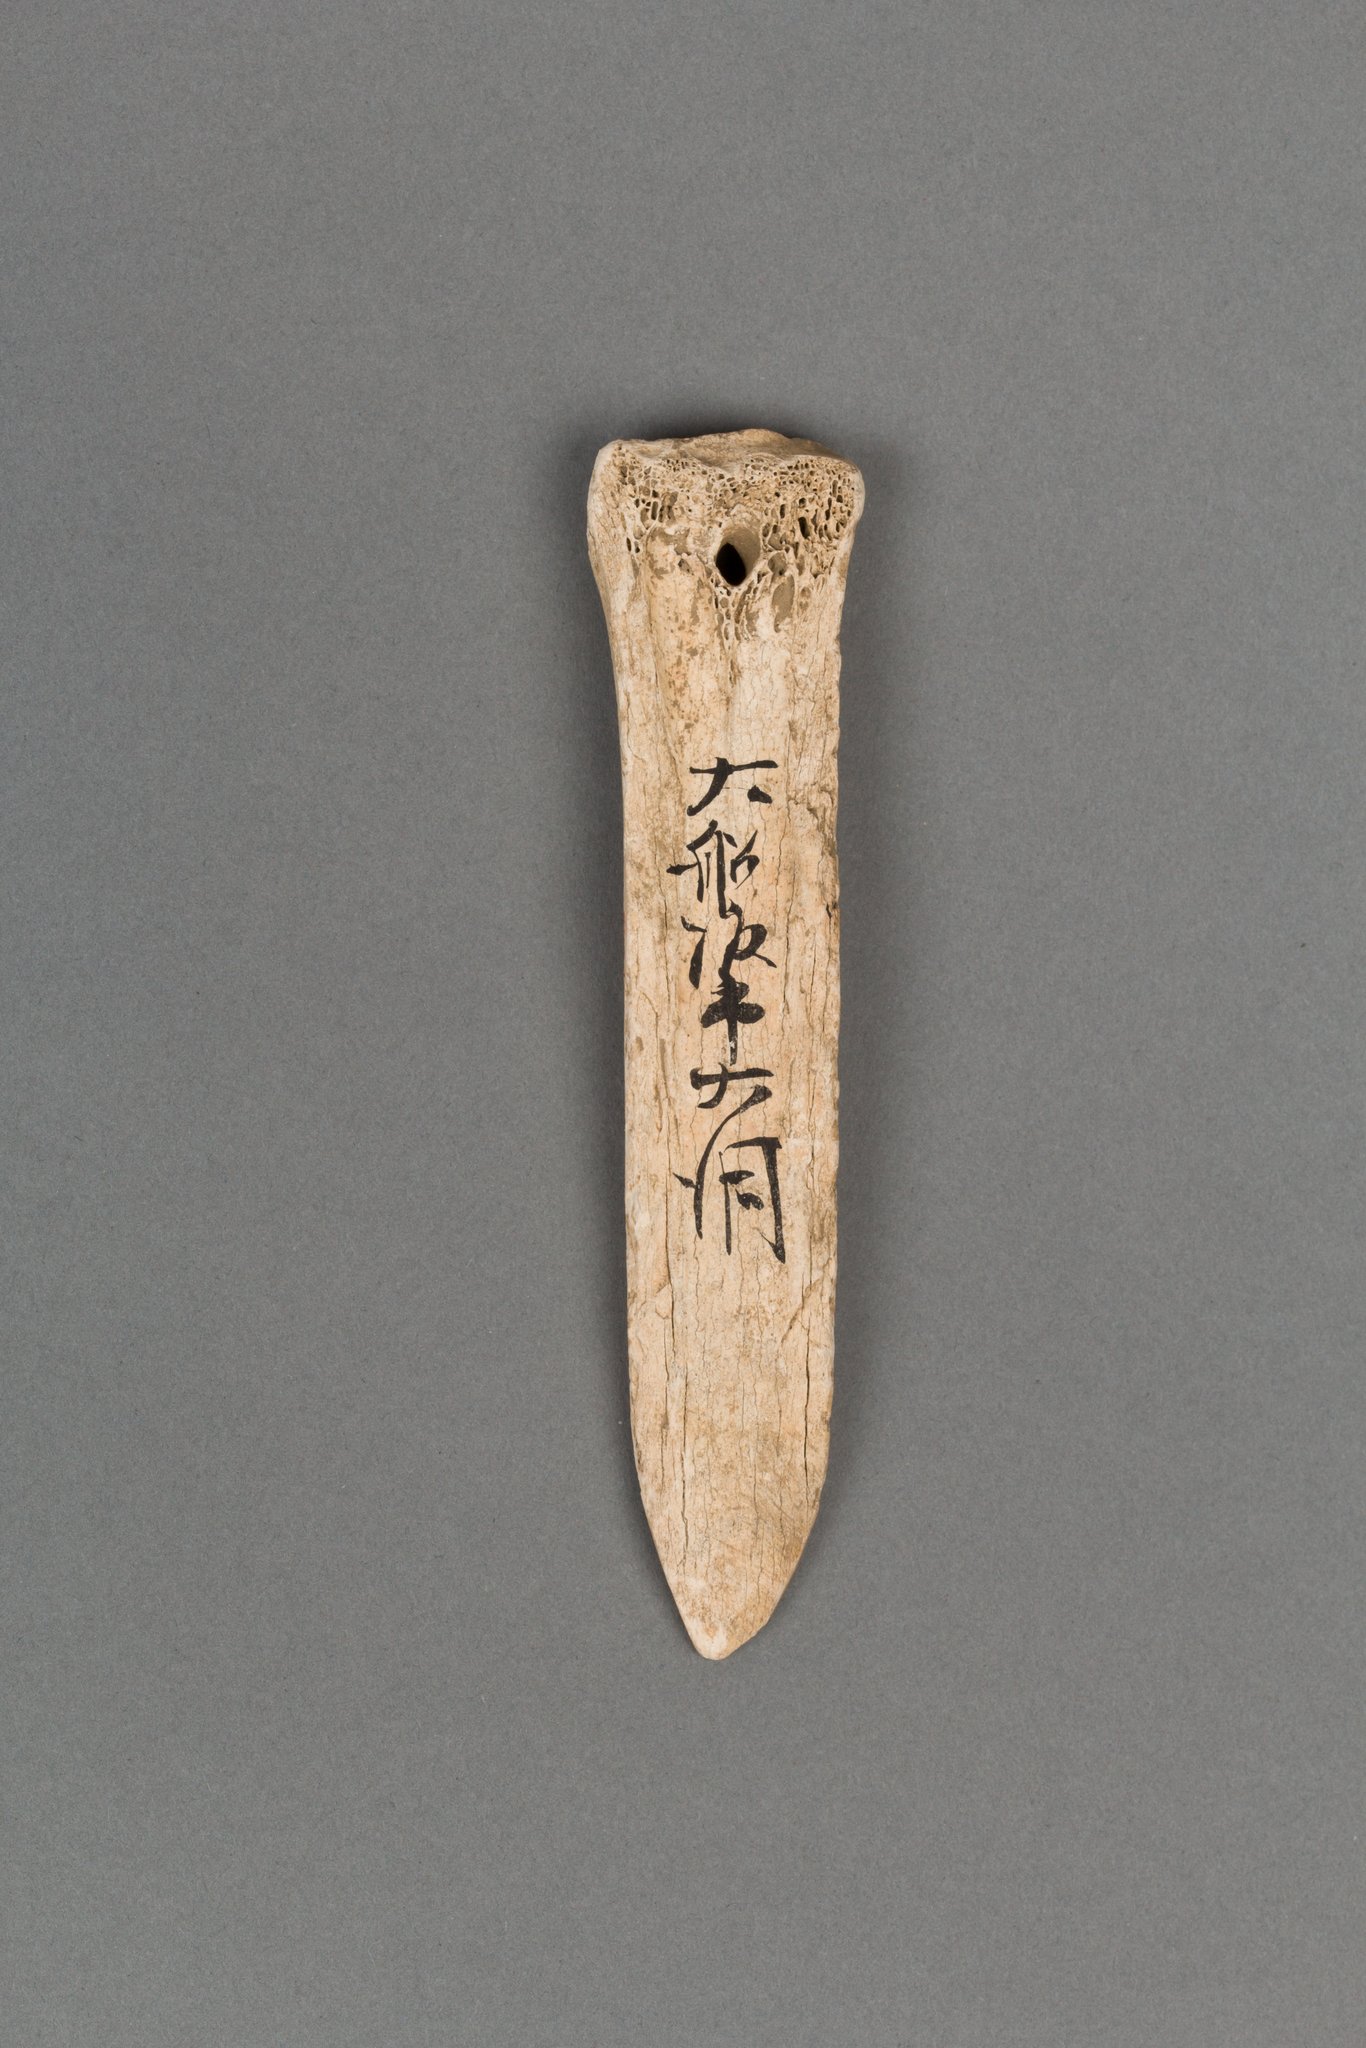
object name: arrowhead, needle, hook and harpoon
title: Arrowheads, needles, hooks and harpoons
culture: japanese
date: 1200-200 BCE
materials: bone